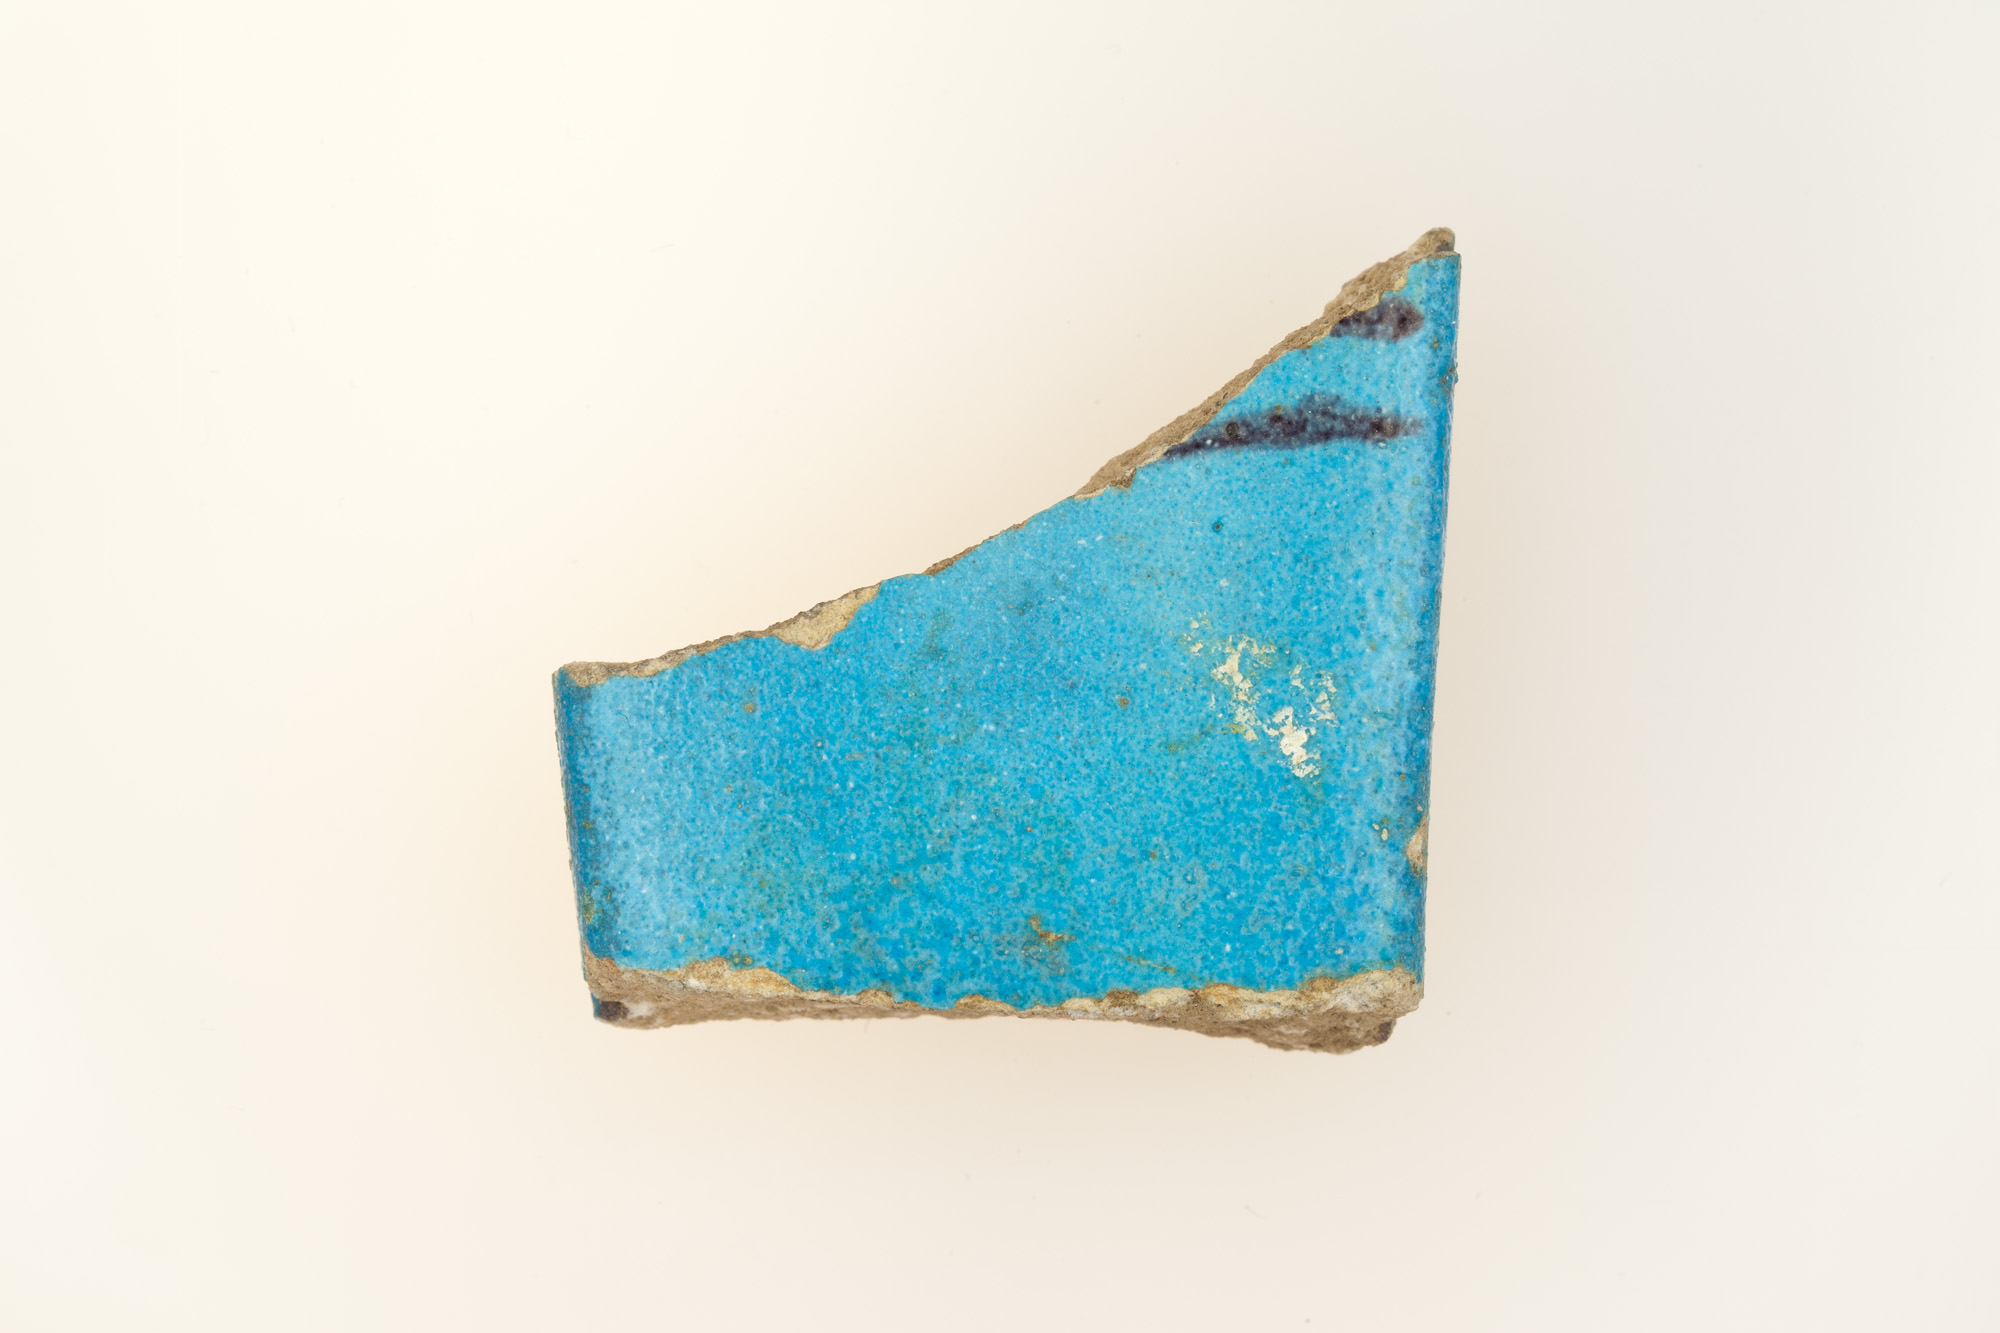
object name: menat fragment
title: Votive Menat fragments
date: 1479-1458 BCE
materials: faience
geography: egypt